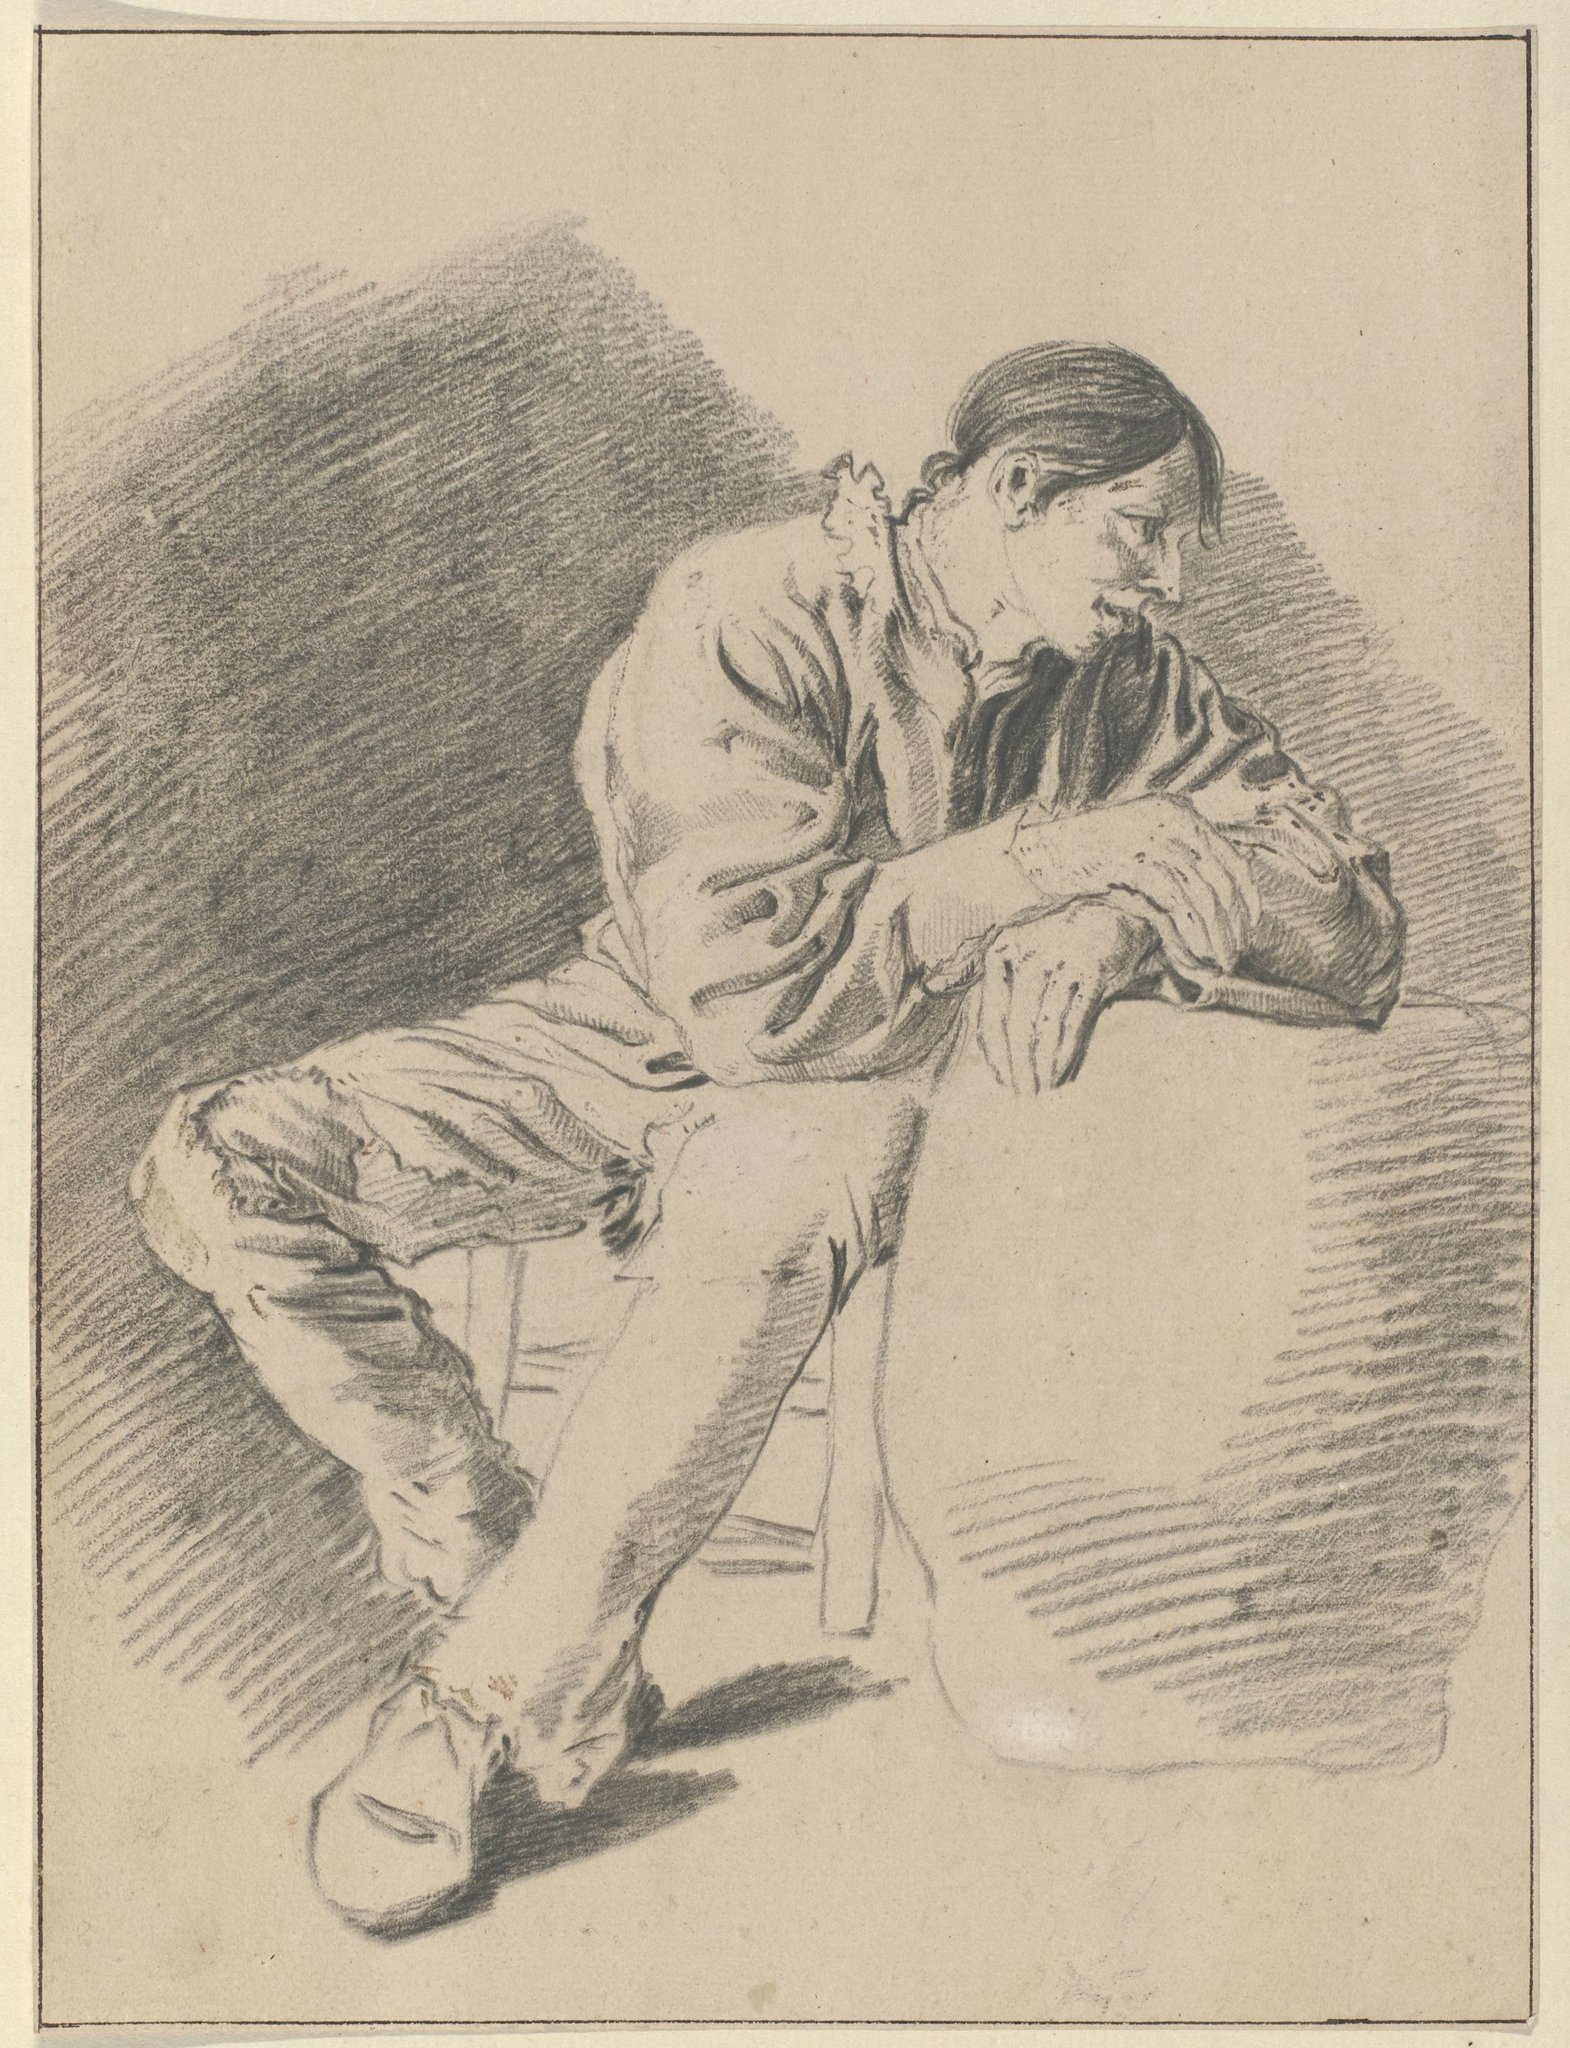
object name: drawing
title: Seated Man, Leaning on a Barrel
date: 1650-1700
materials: chalk, paper